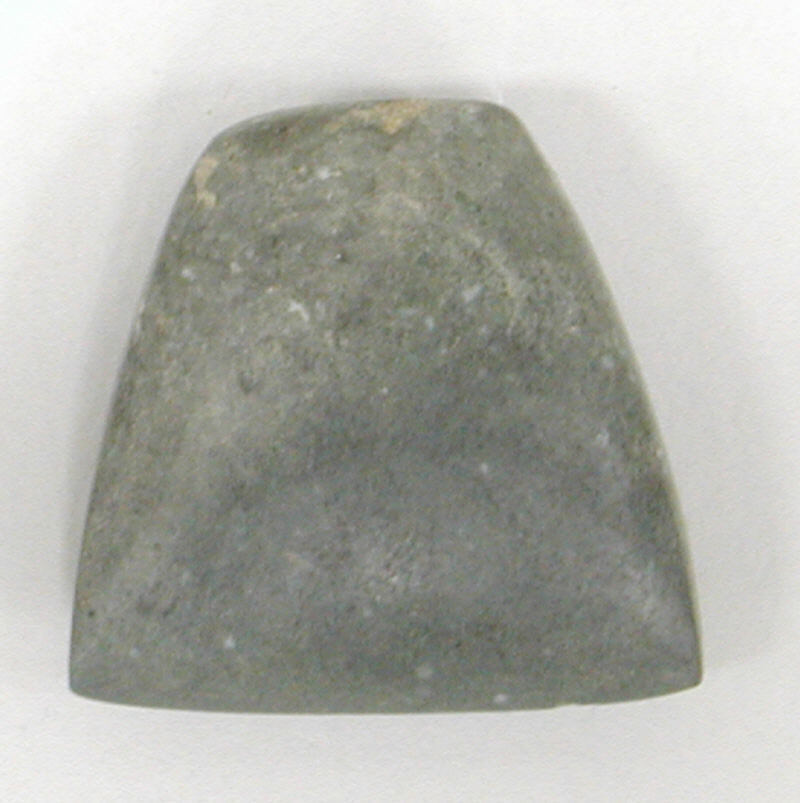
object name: celt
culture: maya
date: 1501-1600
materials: stone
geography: guatemala